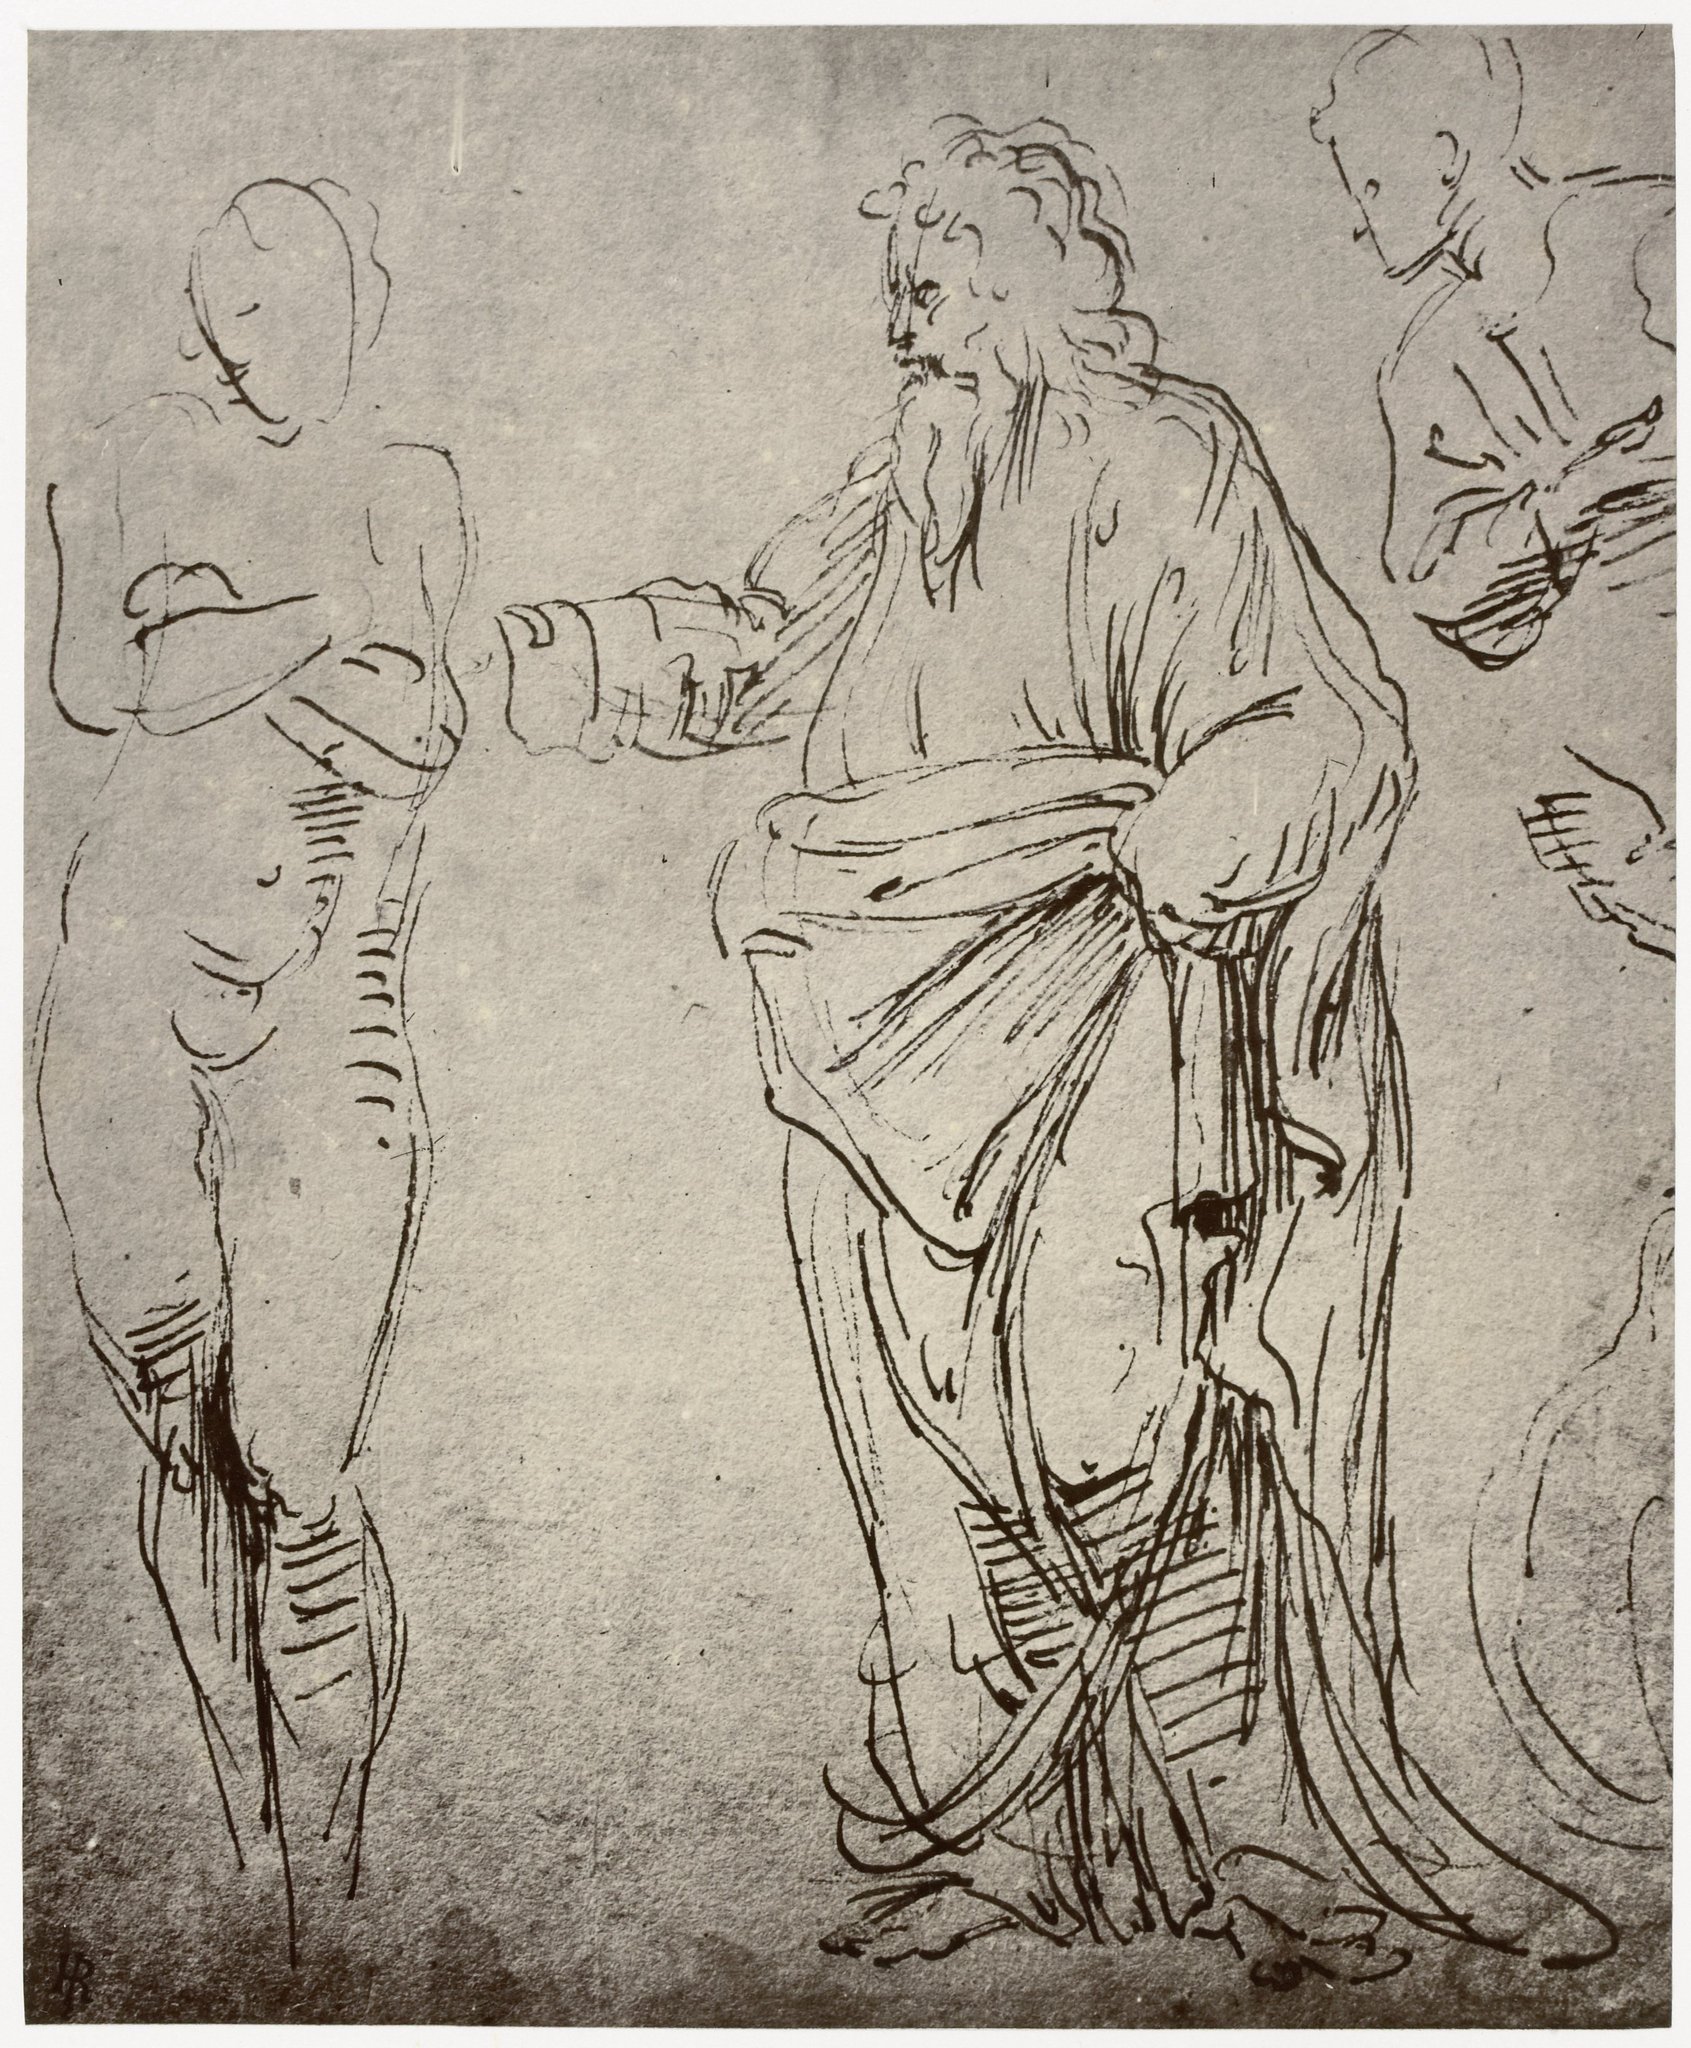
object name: photograph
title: Rafaël, The Formation of Eve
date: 1855-1858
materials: cardboard, paper, photographic support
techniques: albumen print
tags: drawing, sketch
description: Fotoreproductie van tekening in 'The Reveley Collection of Drawings at Brynygwin', afb. 33.